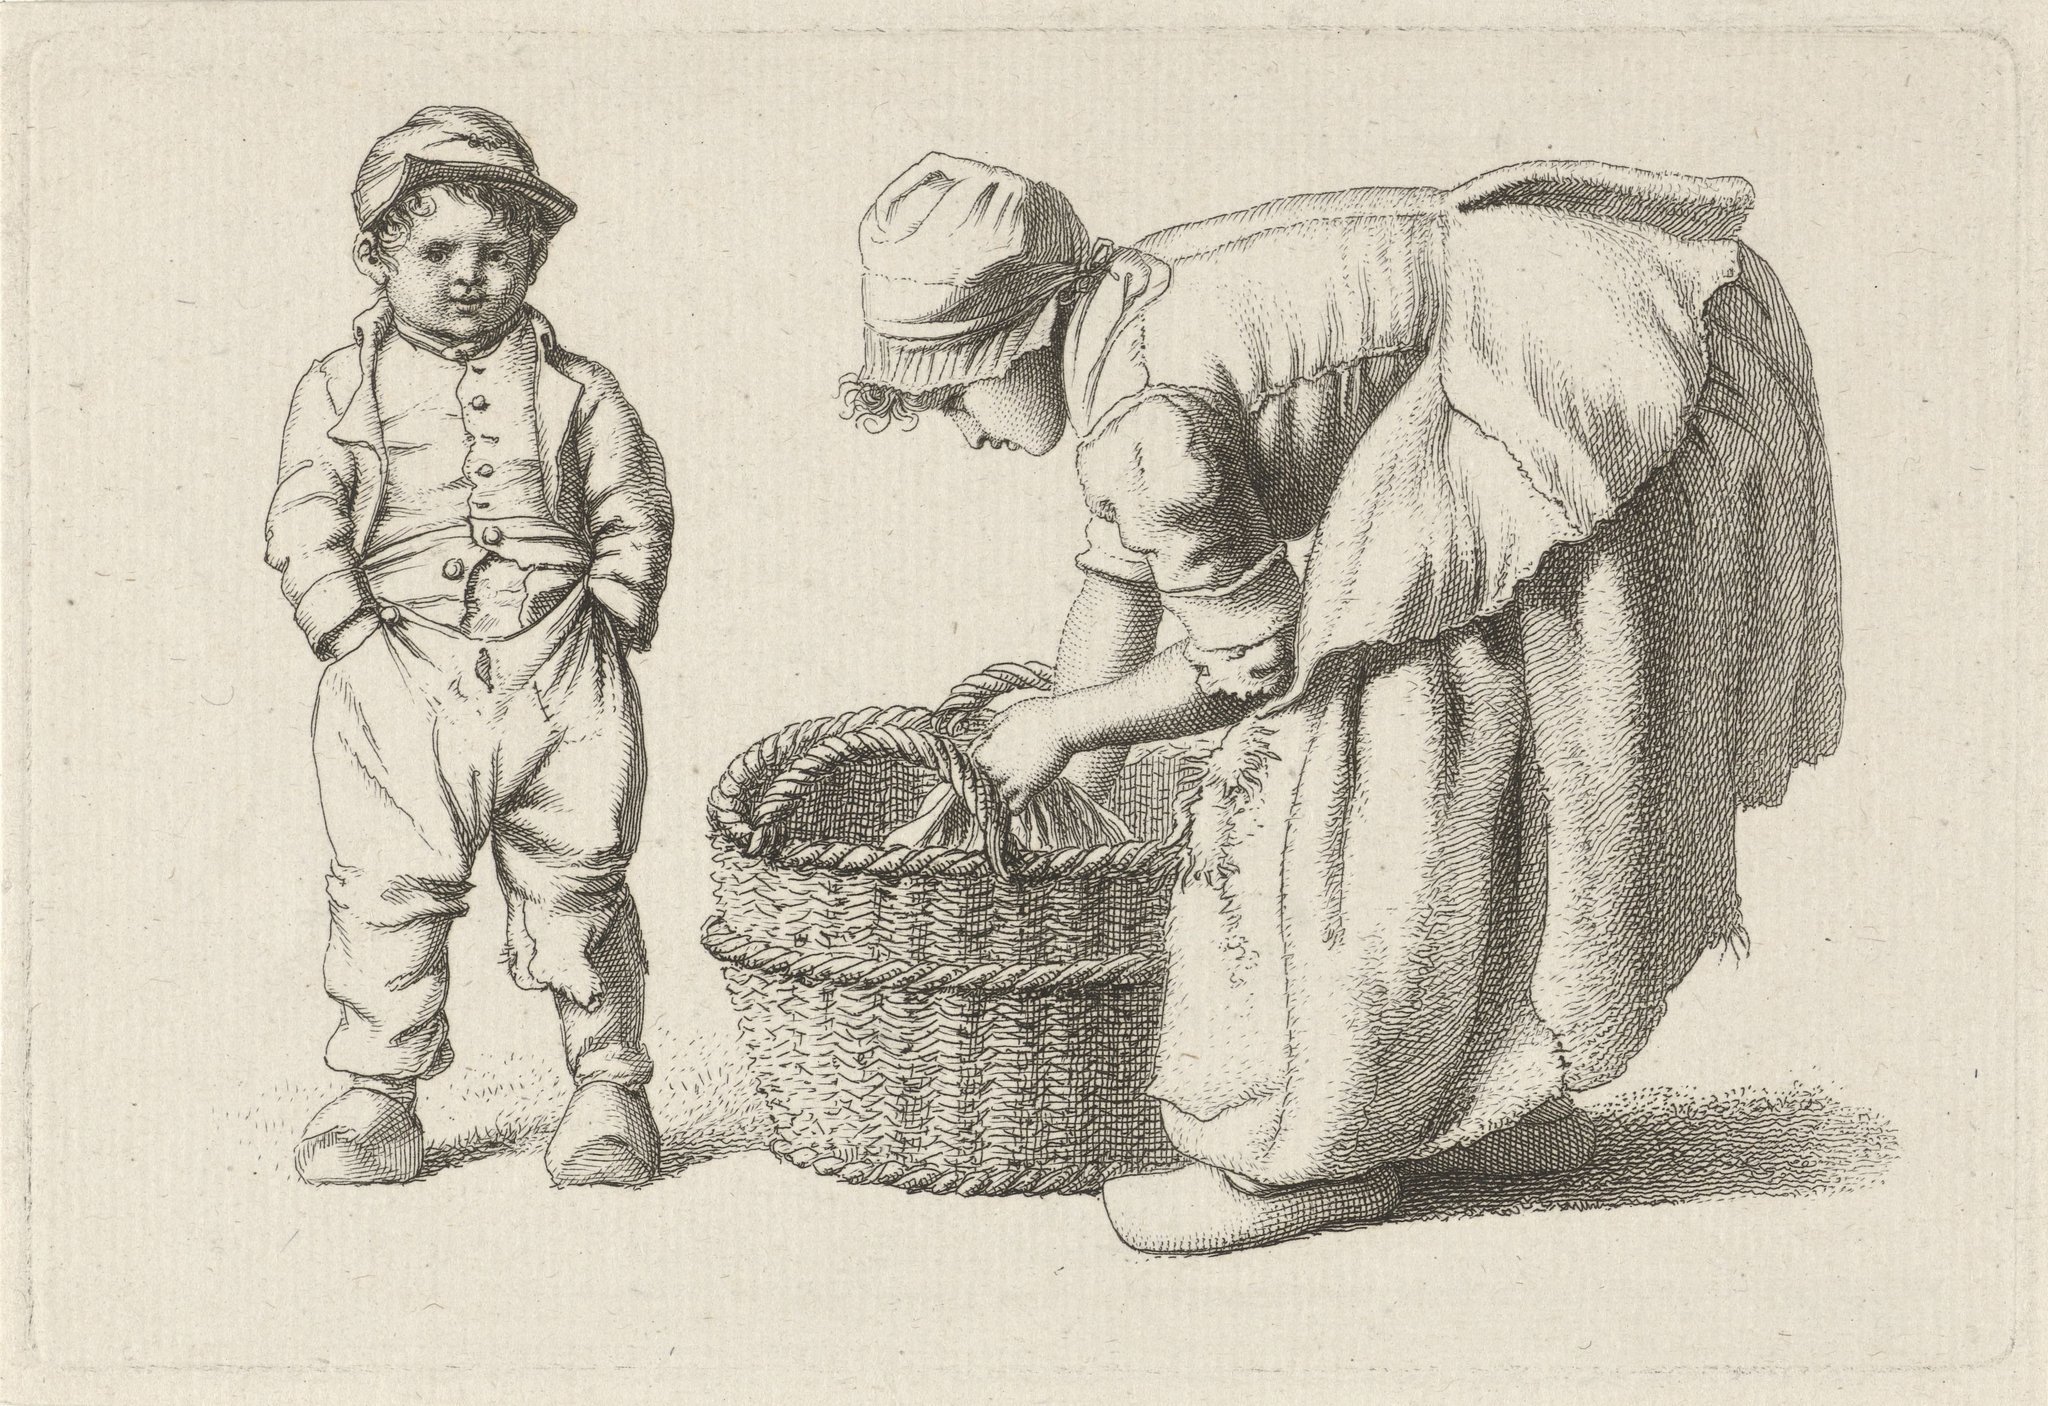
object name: print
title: Studie-prentwerk / Etudes gravées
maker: jacob ernst marcus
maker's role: draughtsman, print maker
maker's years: 1774-1826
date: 1802-1813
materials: paper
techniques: etching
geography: amsterdam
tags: boy (child between toddler and youth) (+ standing), bending figure - aa - female human figure (+ left side visible; left - (l. hand, l. foot, etc.)), container made of plant material other than wood: basket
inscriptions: collector's mark: Lugt 2228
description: Serie voor het eerst uitgegeven door Jacob Ernst Marcus onder de titel Studiebeelden en Fragmenten. Amsterdam: ca.1816. Later heruitgegeven als: Studie-prentwerk/ Etudes gravées.